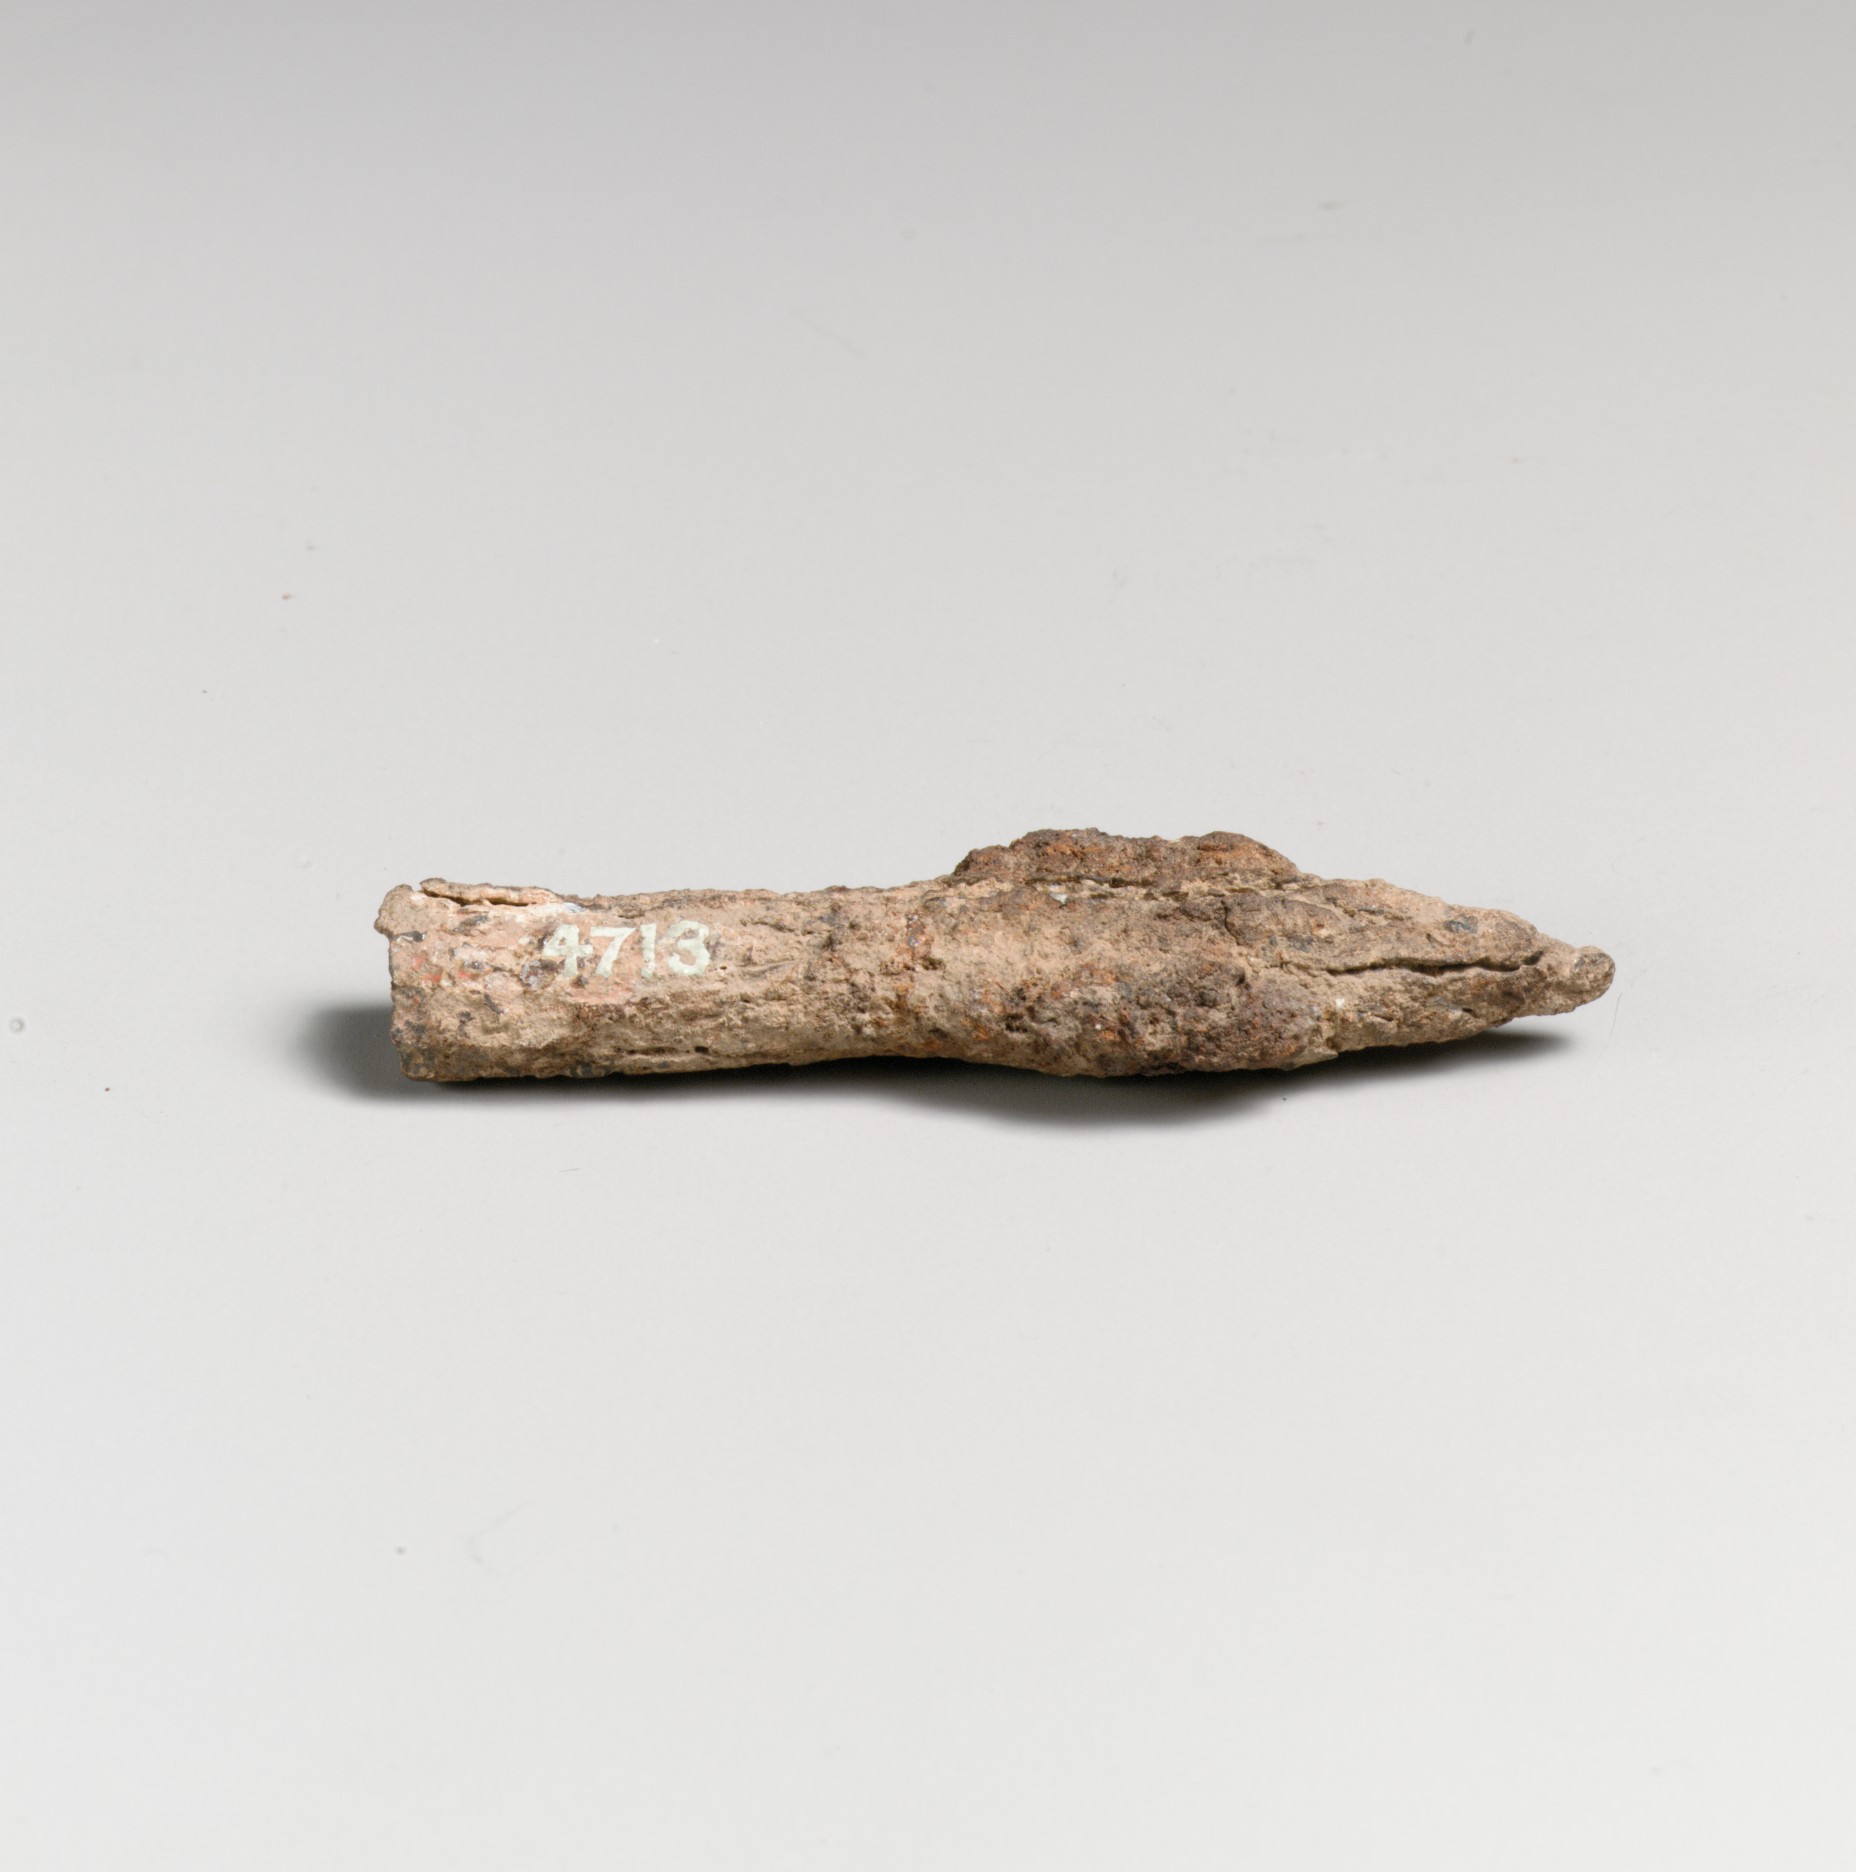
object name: spearhead or arrowhead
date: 7000 BCE-330 CE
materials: iron